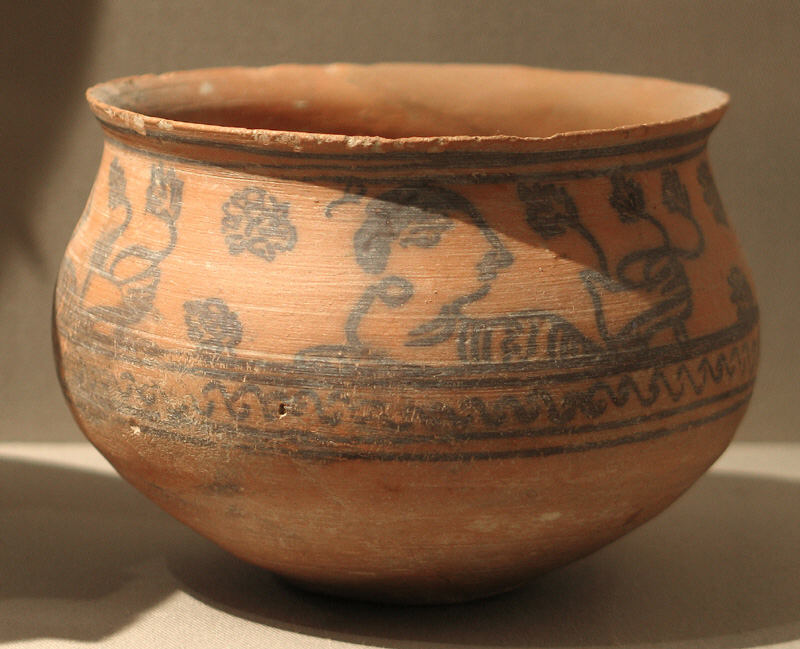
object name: bowl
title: Bowl Decorated with a Procession of Women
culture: pakistani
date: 401-600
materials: ink, terracotta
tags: gandhara